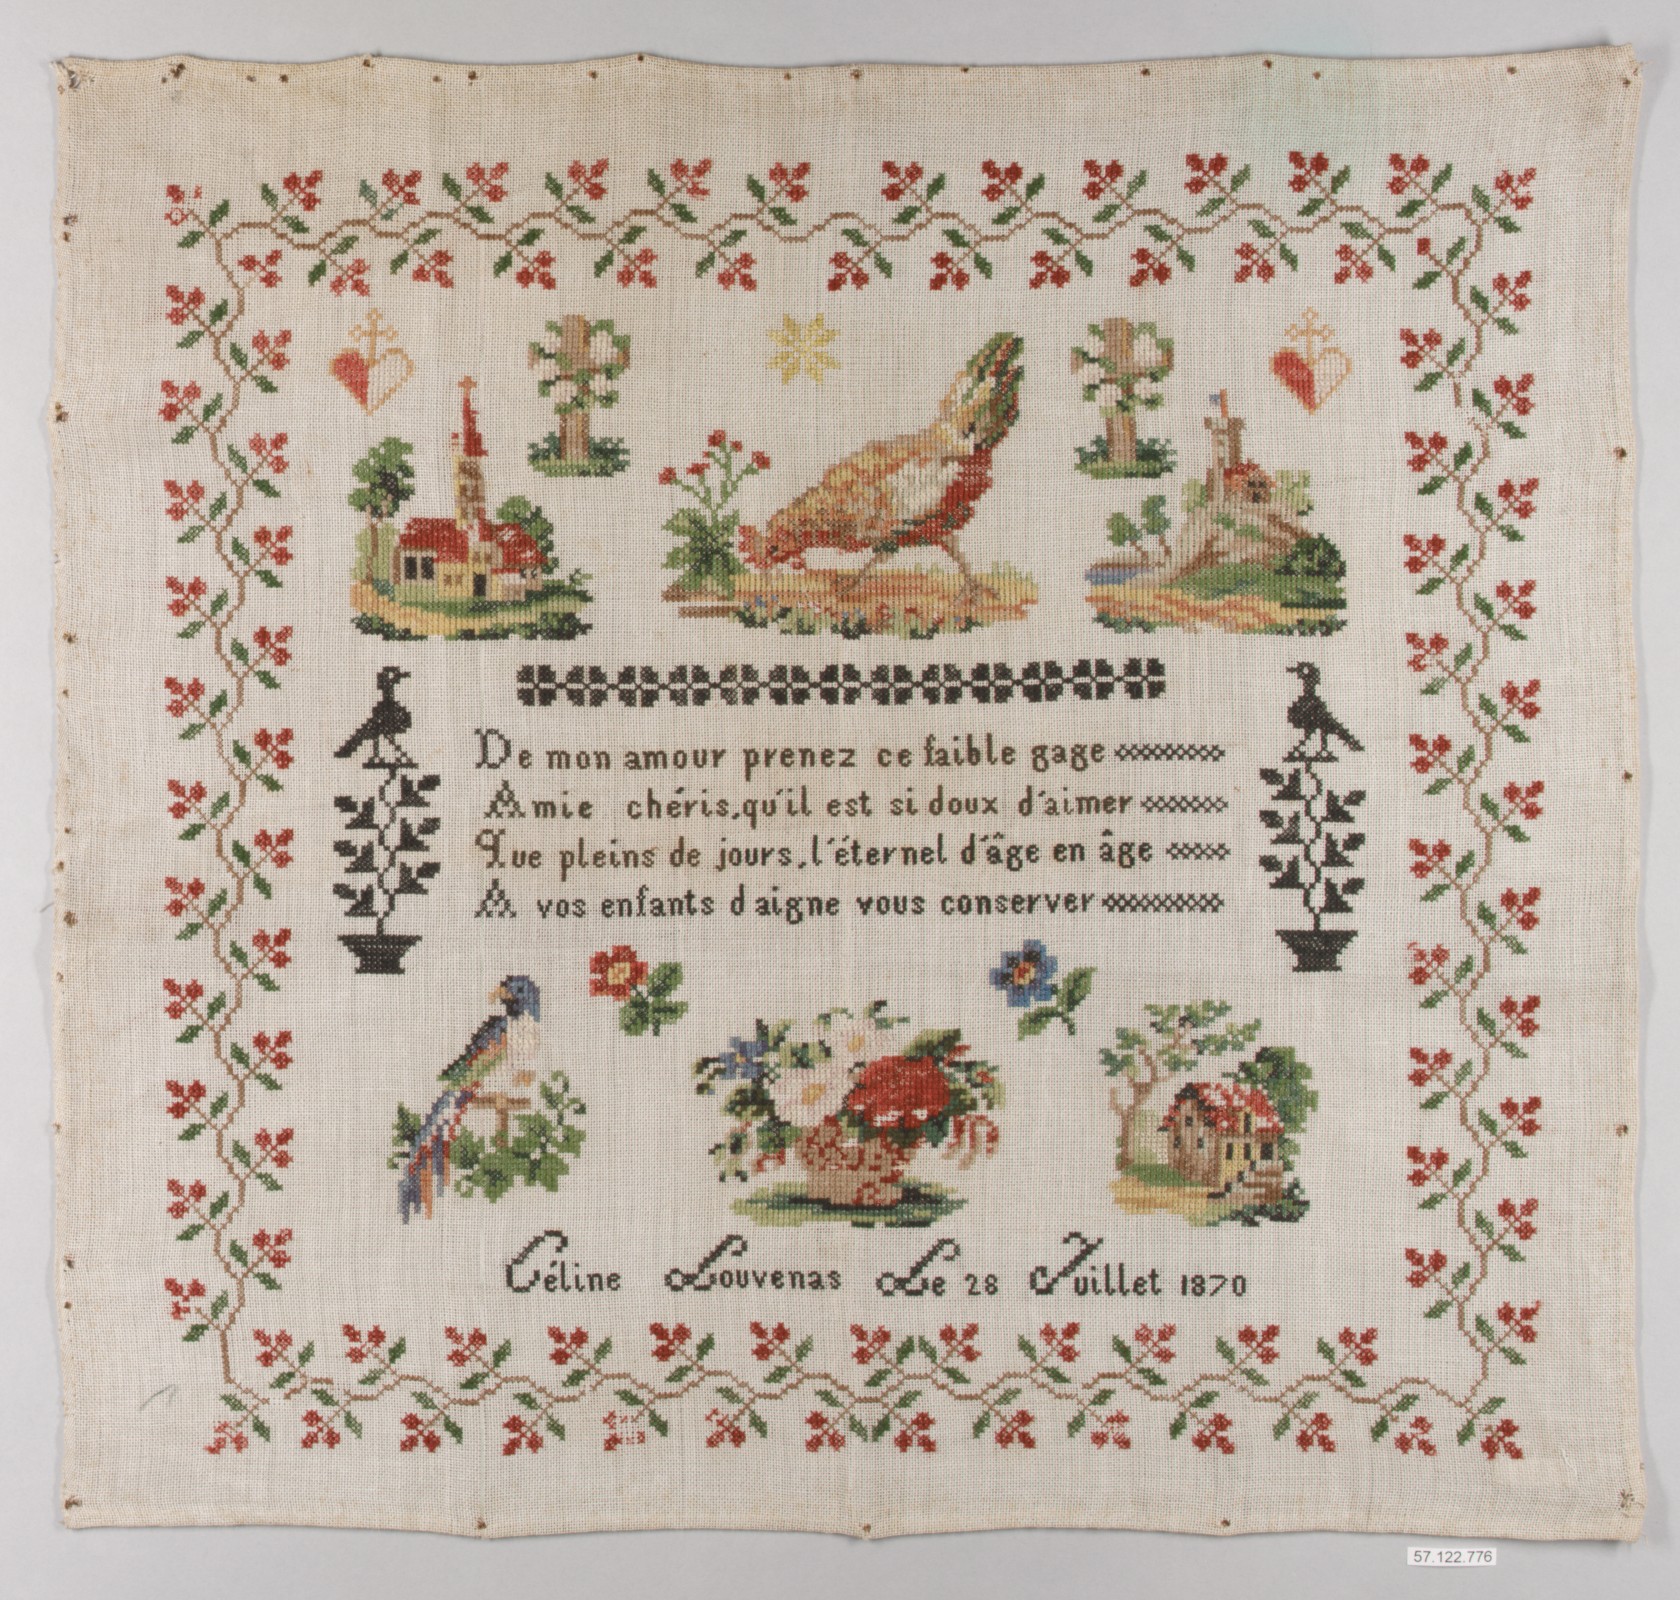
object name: sampler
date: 1870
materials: canvas, wool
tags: birds,houses,flowers